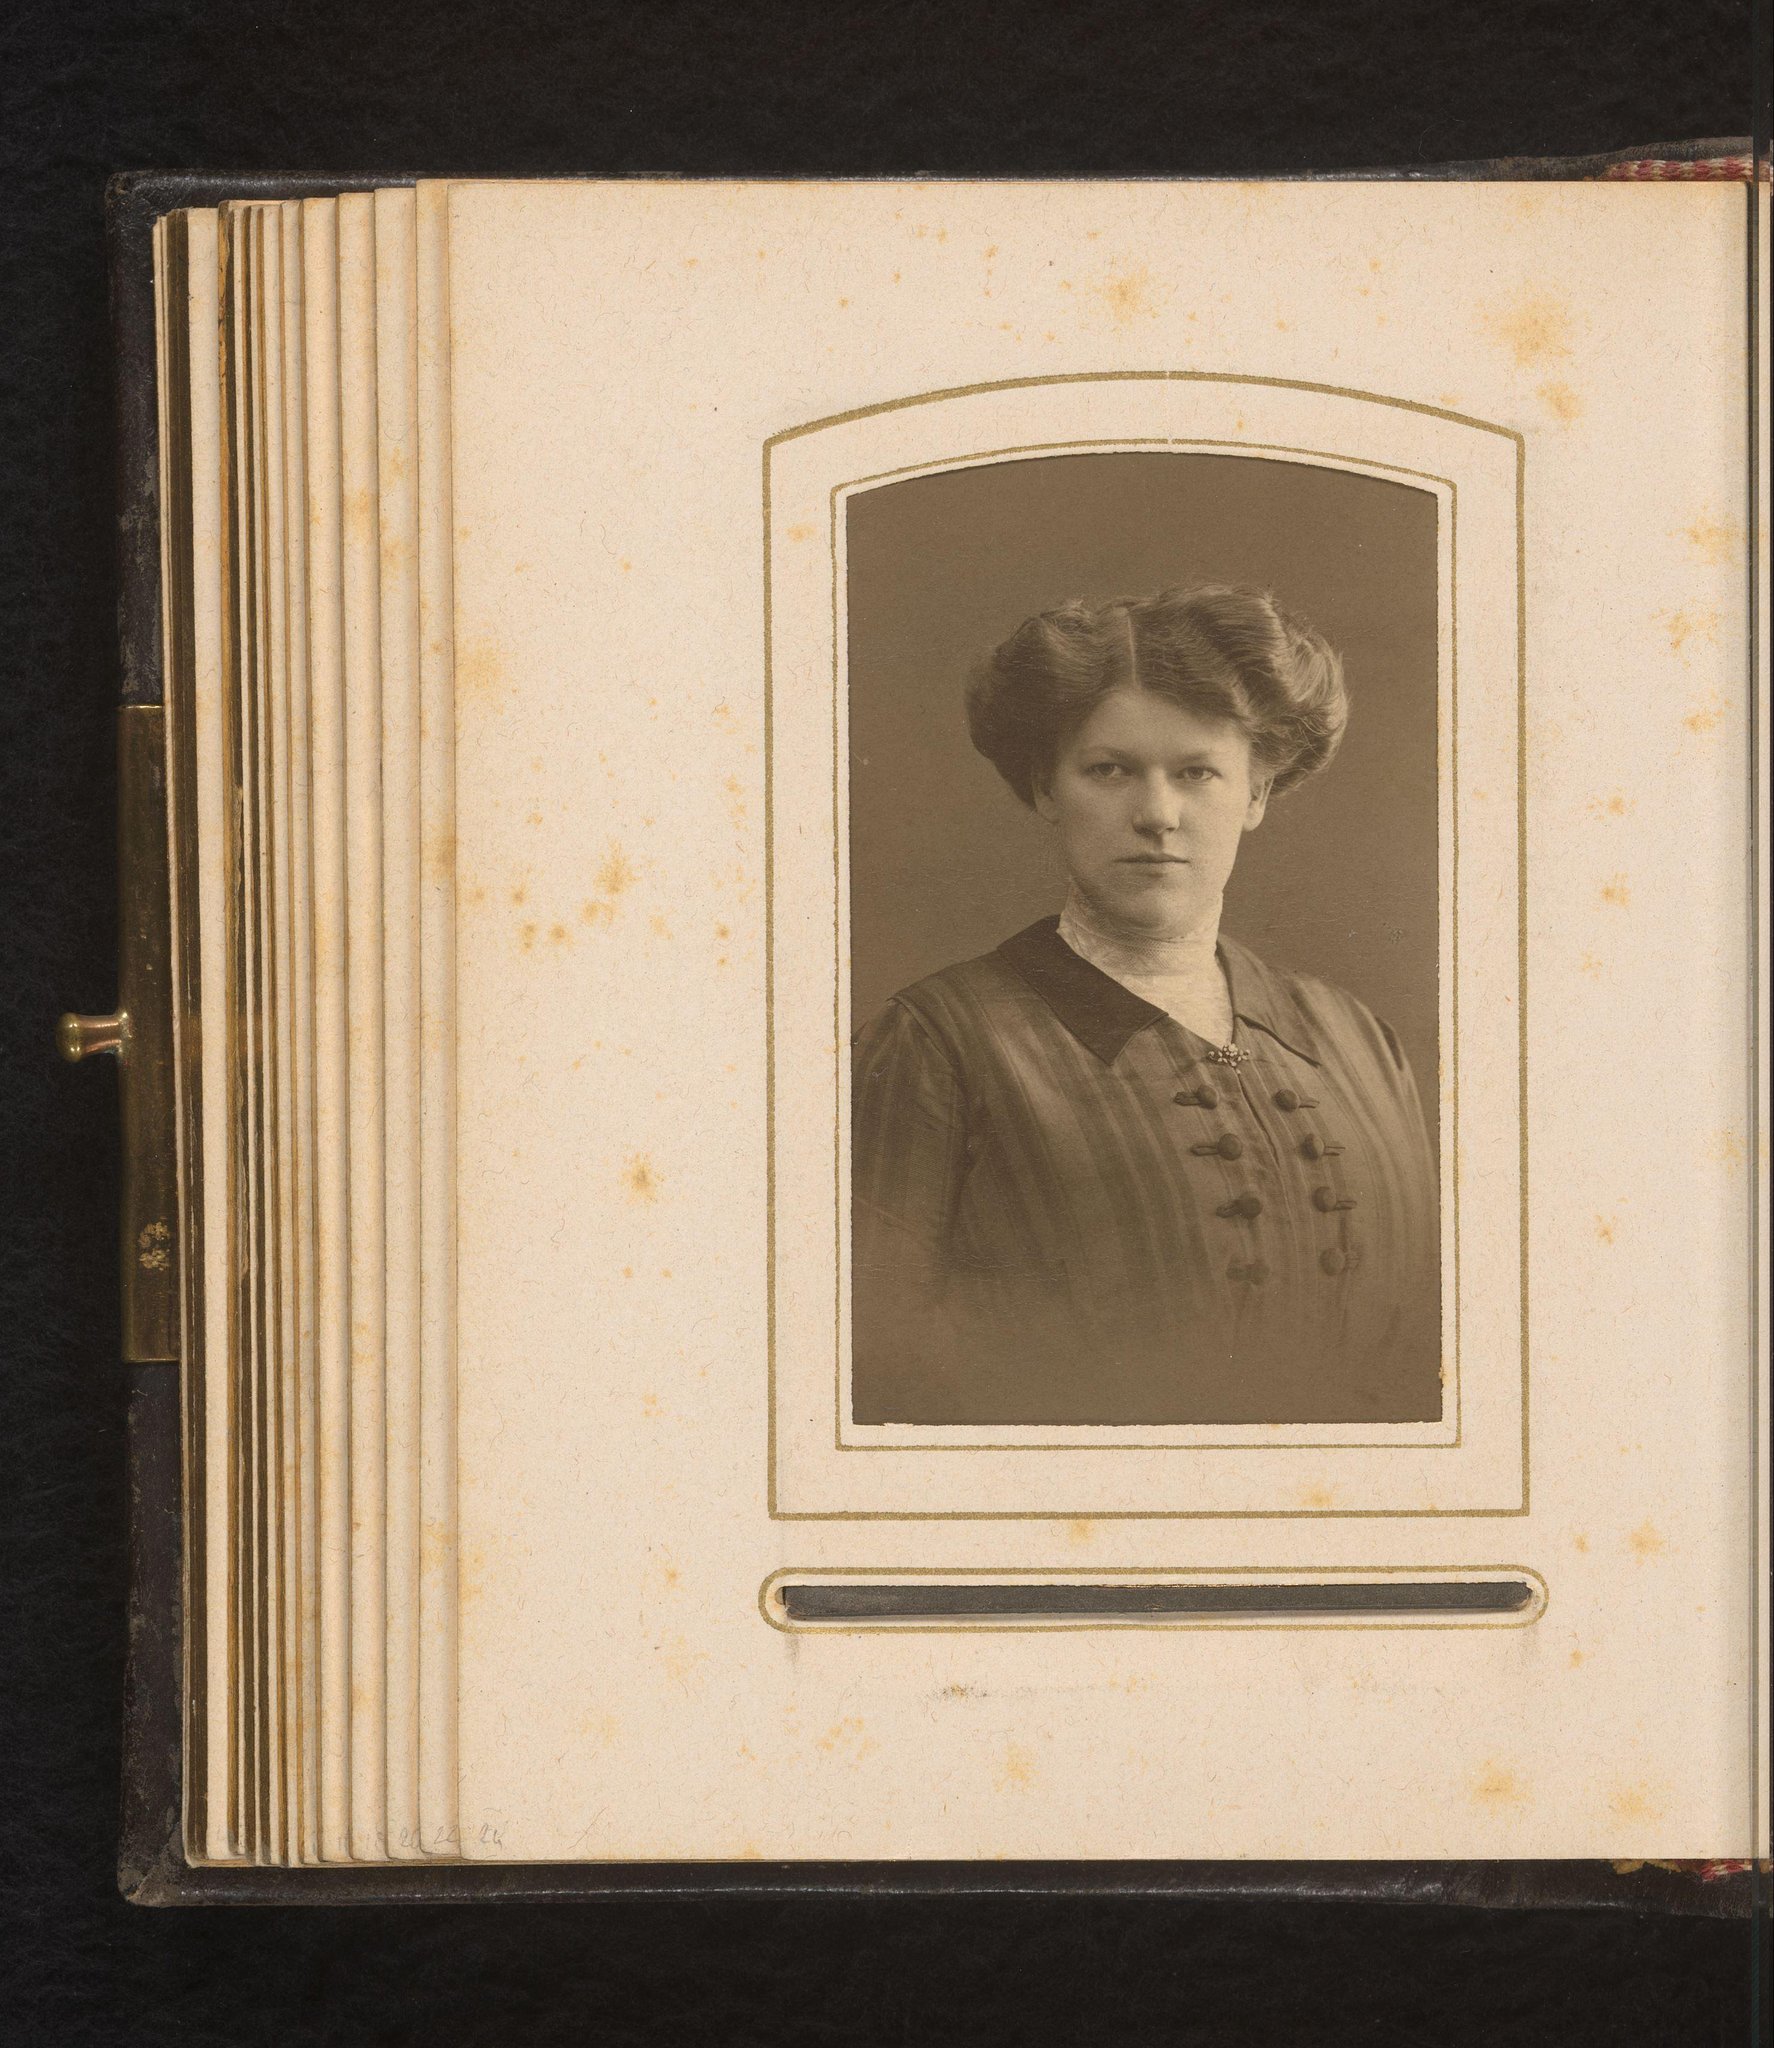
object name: photograph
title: Portret van een vrouw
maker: a. schlegel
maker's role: fotograaf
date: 1880-1920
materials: cardboard, photographic support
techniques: collodion silver print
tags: adult woman, historical persons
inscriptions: inscription: ‘A. Schlegel & Co./ Atelier für Künstlerische/ portraits/ Bremen/ Am Brill (Rolandhaus)/ (...)’